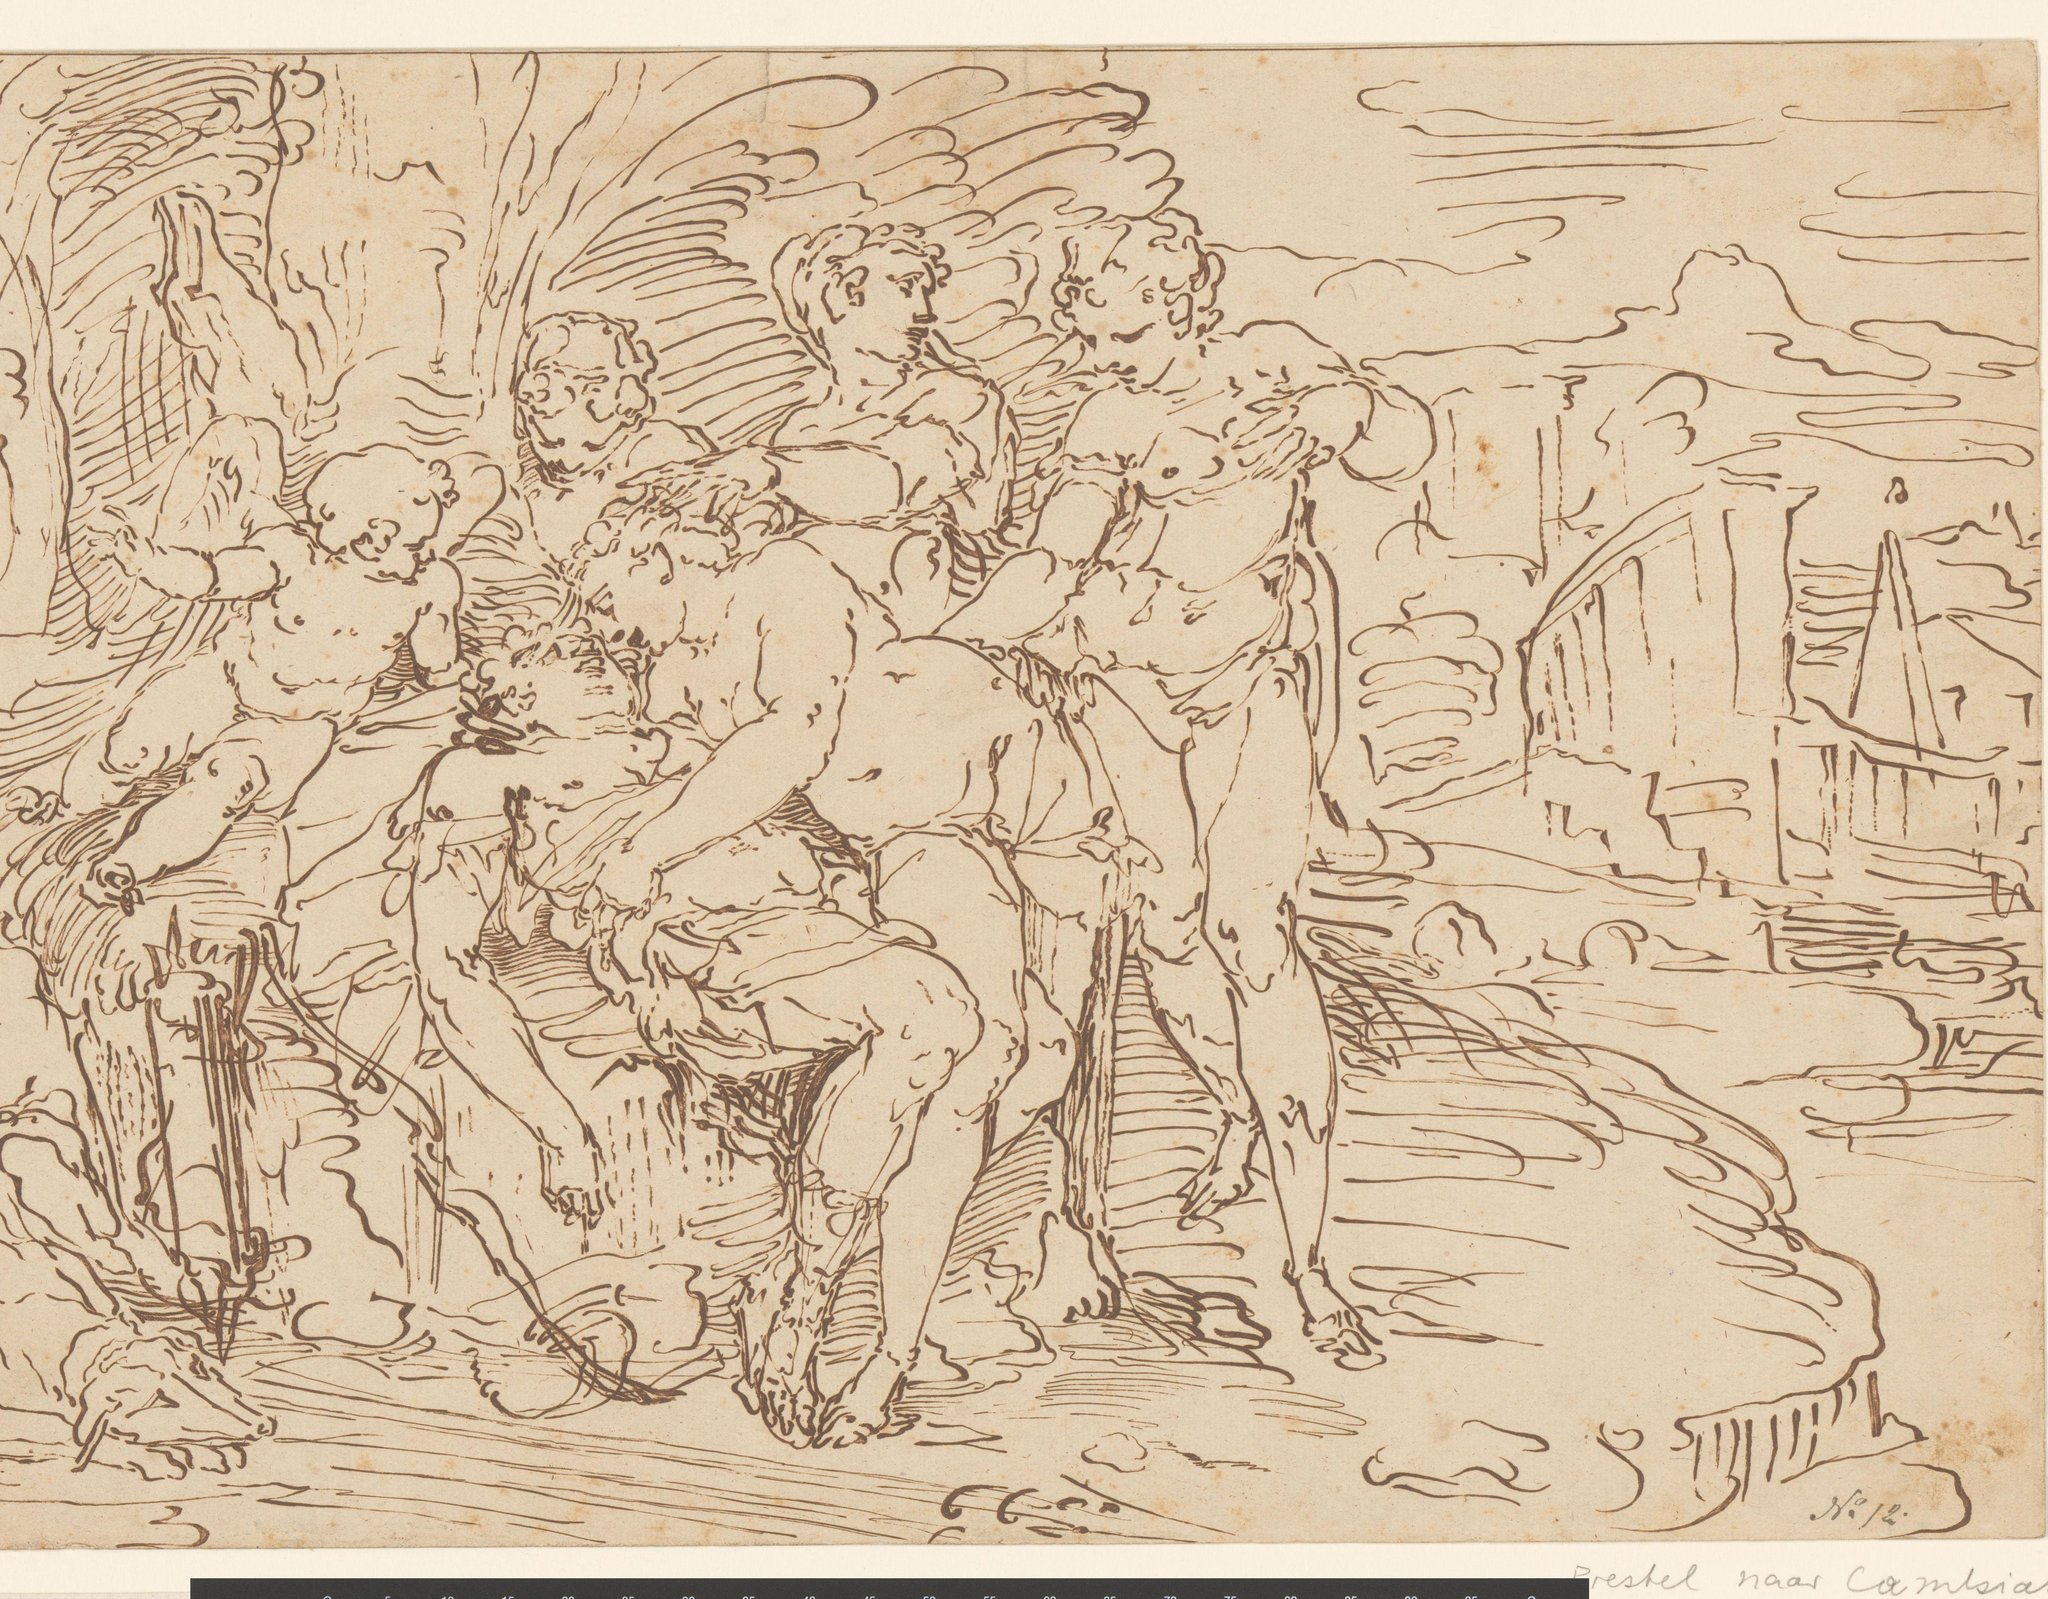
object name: print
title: Venus kust de dode Adonis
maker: johann gottlieb prestel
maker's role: draughtsman, painter, print maker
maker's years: 1739-1808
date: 1783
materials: paper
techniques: etching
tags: venus mourning adonis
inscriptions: number: ‘No. 12.’, collector's mark: Lugt 2228